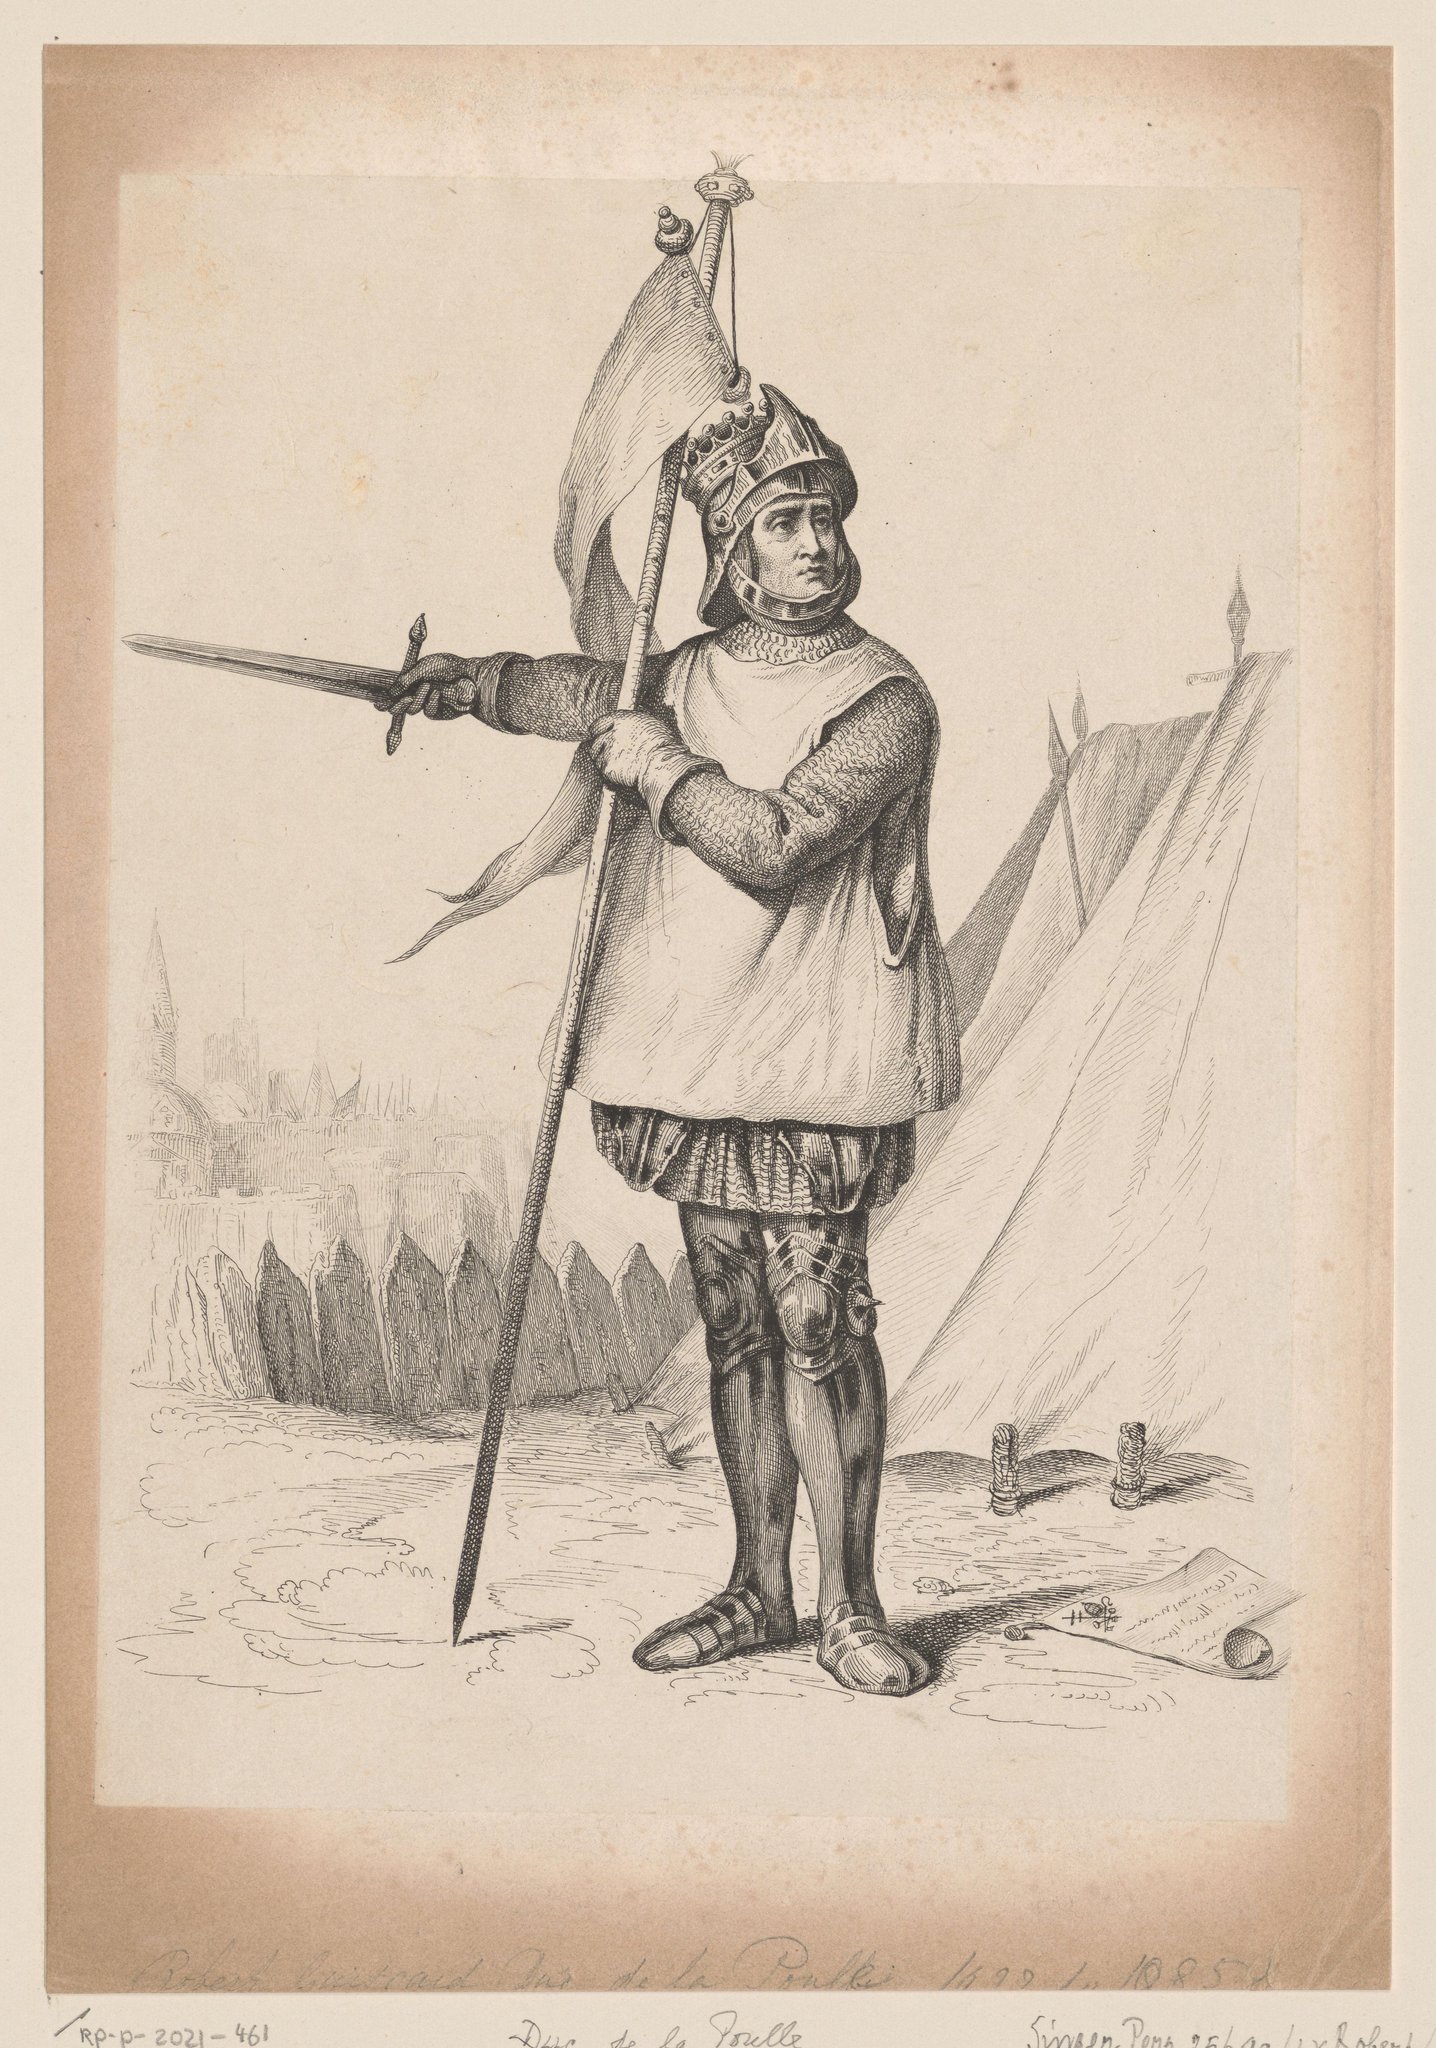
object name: print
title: Portret van Robert Guiscard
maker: Anonymous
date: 1700-1800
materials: paper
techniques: etching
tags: commander-in-chief, general, marshal, historical persons, knight